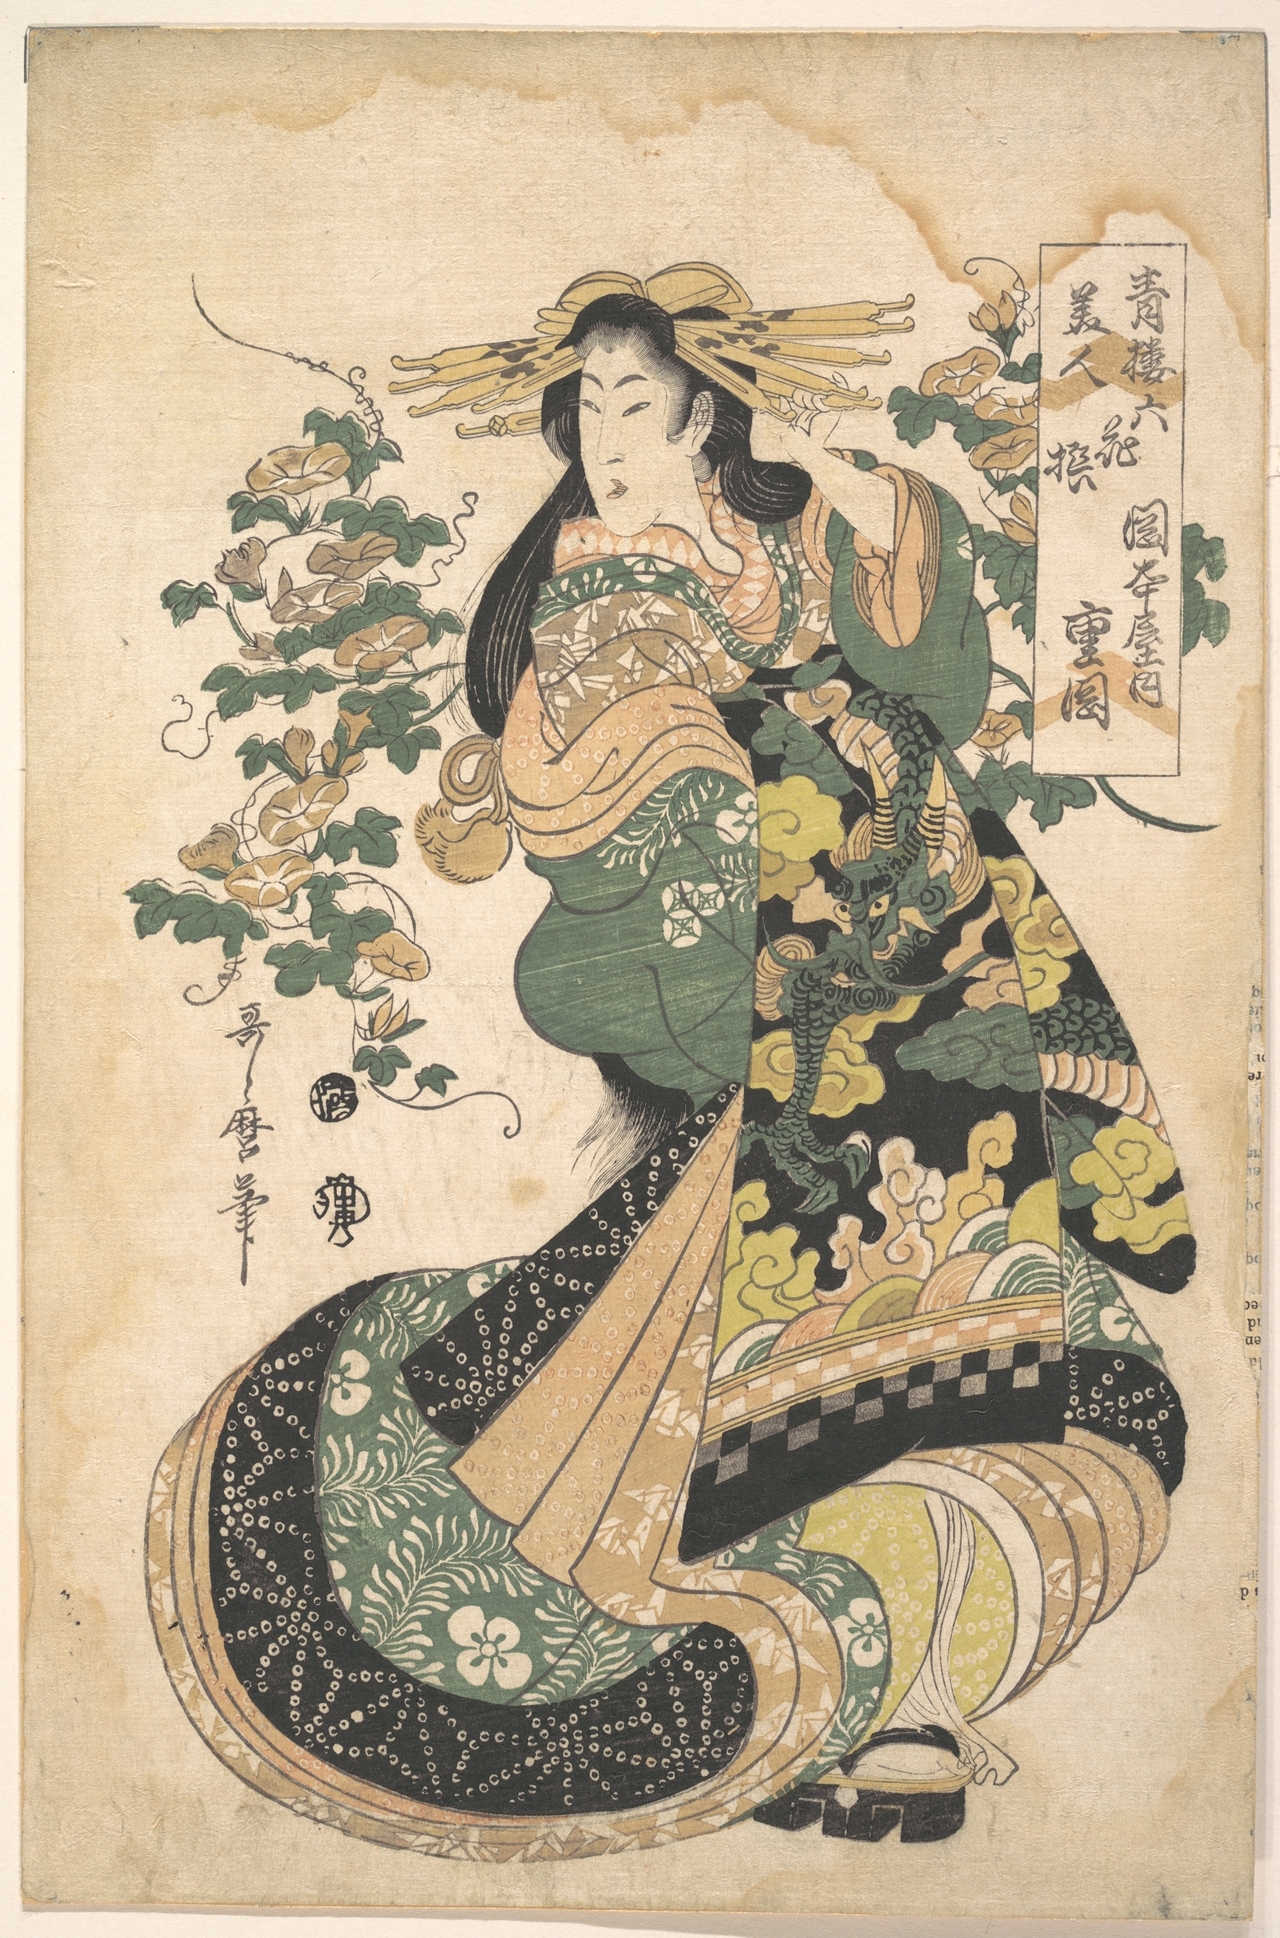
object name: print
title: A Courtesan with Morning-glories on the Background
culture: japanese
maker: utamaro ii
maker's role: artist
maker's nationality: japanese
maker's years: 1750-1850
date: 1615-1831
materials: ink, paper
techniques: woodblock print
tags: women,flowers,leaves